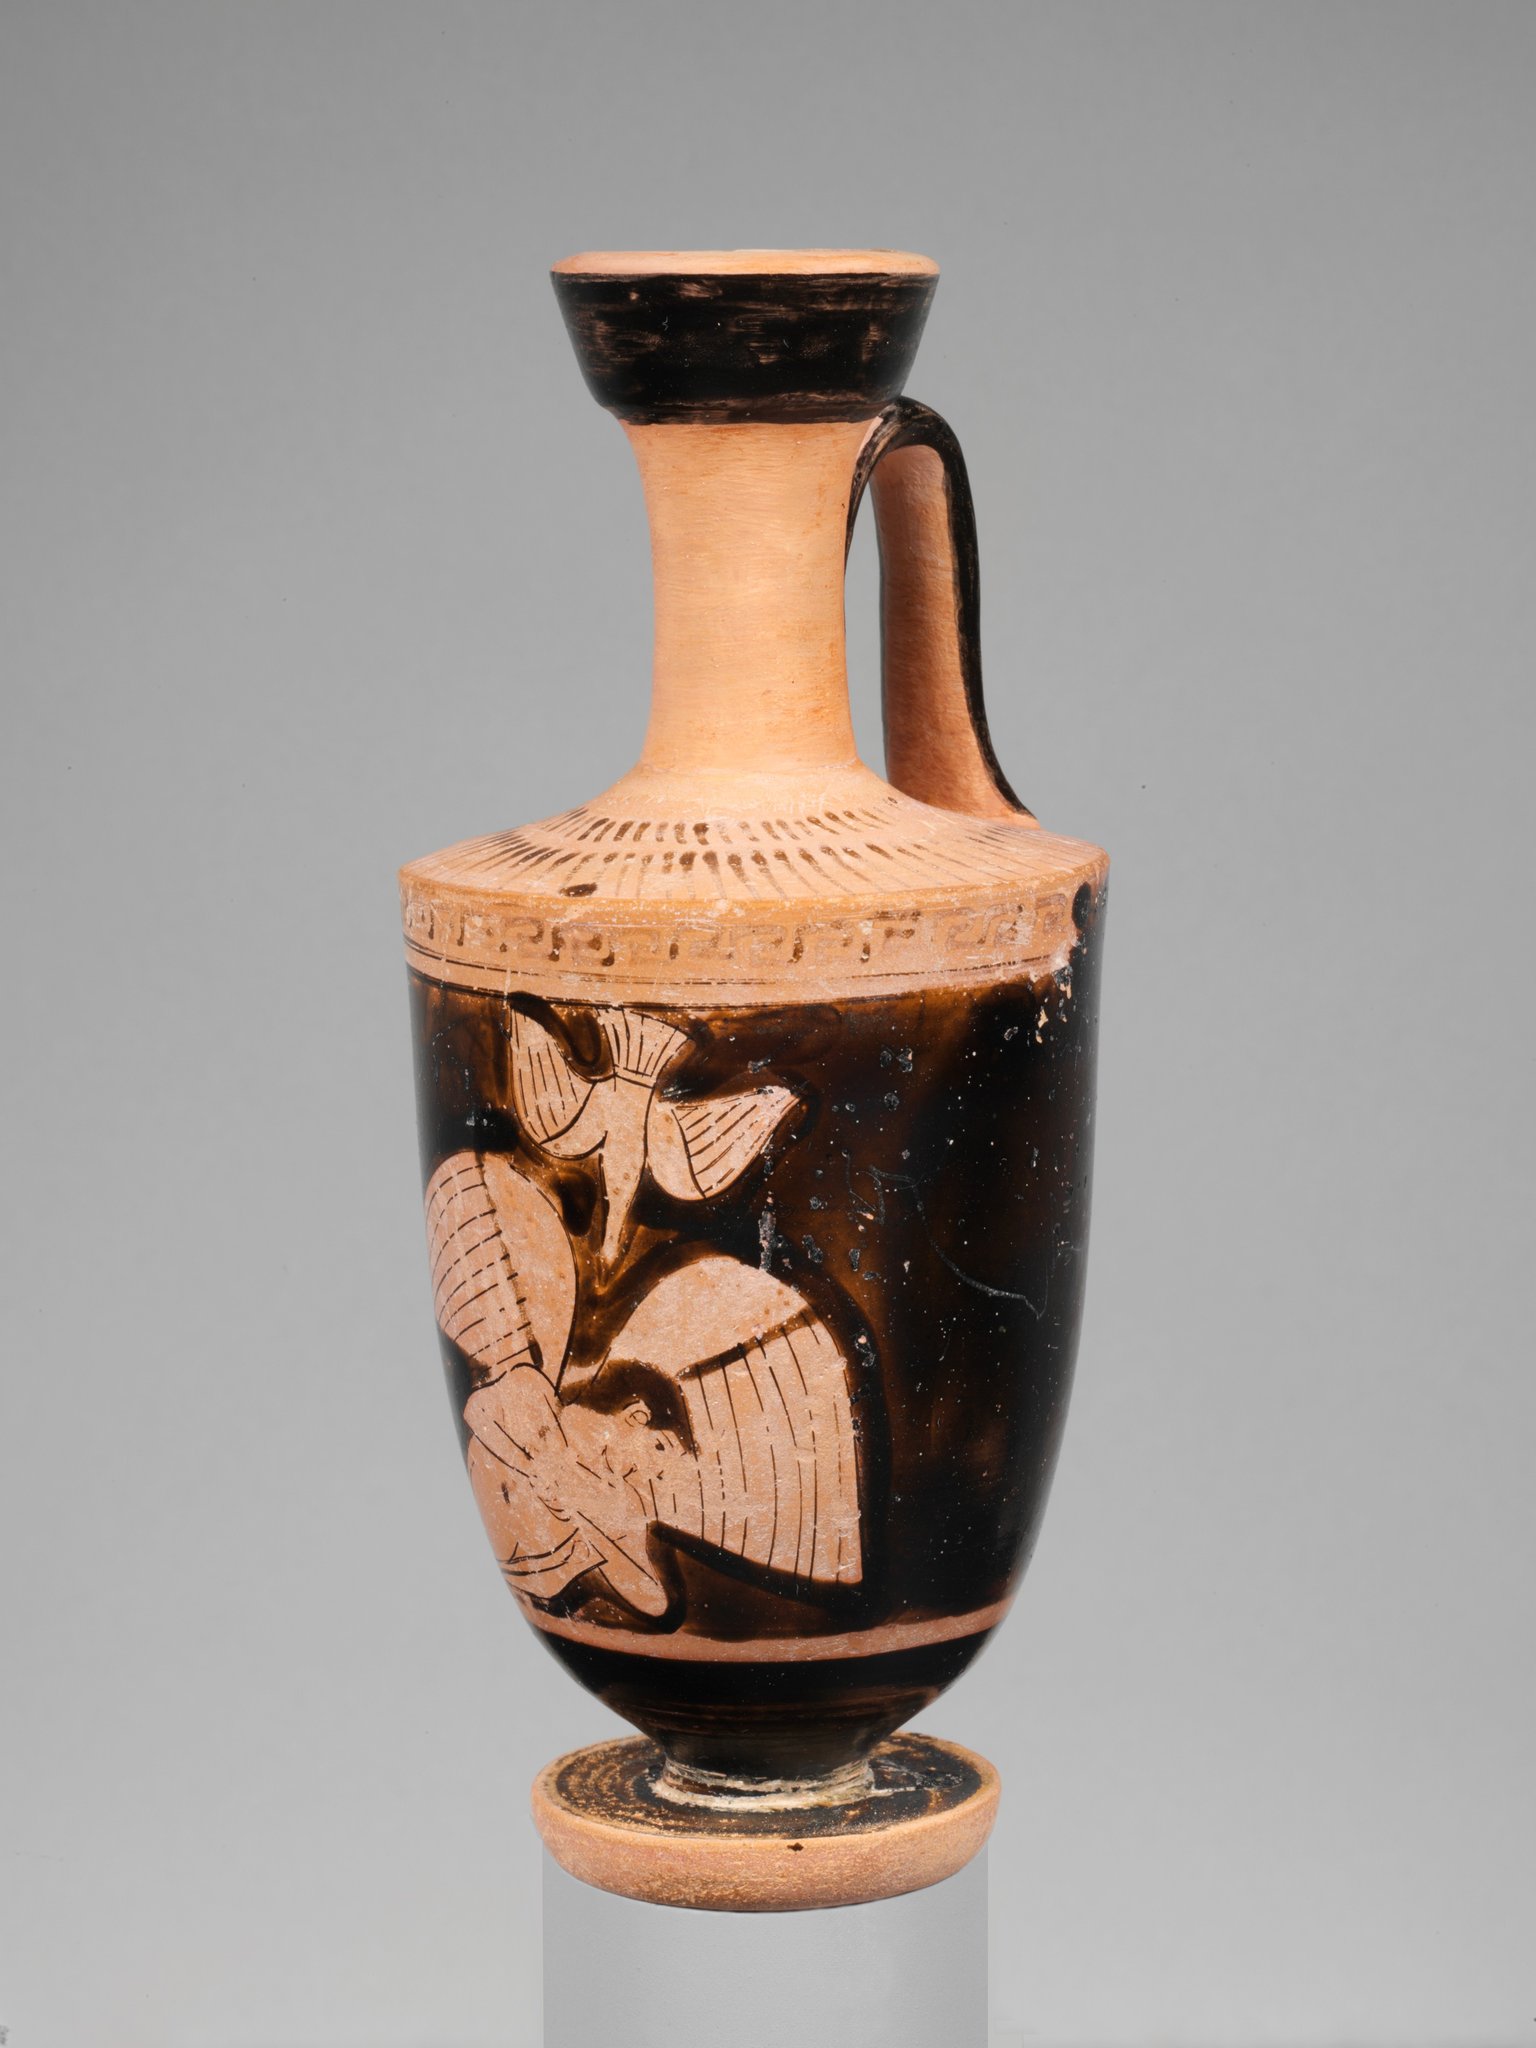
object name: lekythos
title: Terracotta lekythos (oil flask)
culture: greek, attic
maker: icarus painter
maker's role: artist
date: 475-451 BCE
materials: terracotta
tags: birds